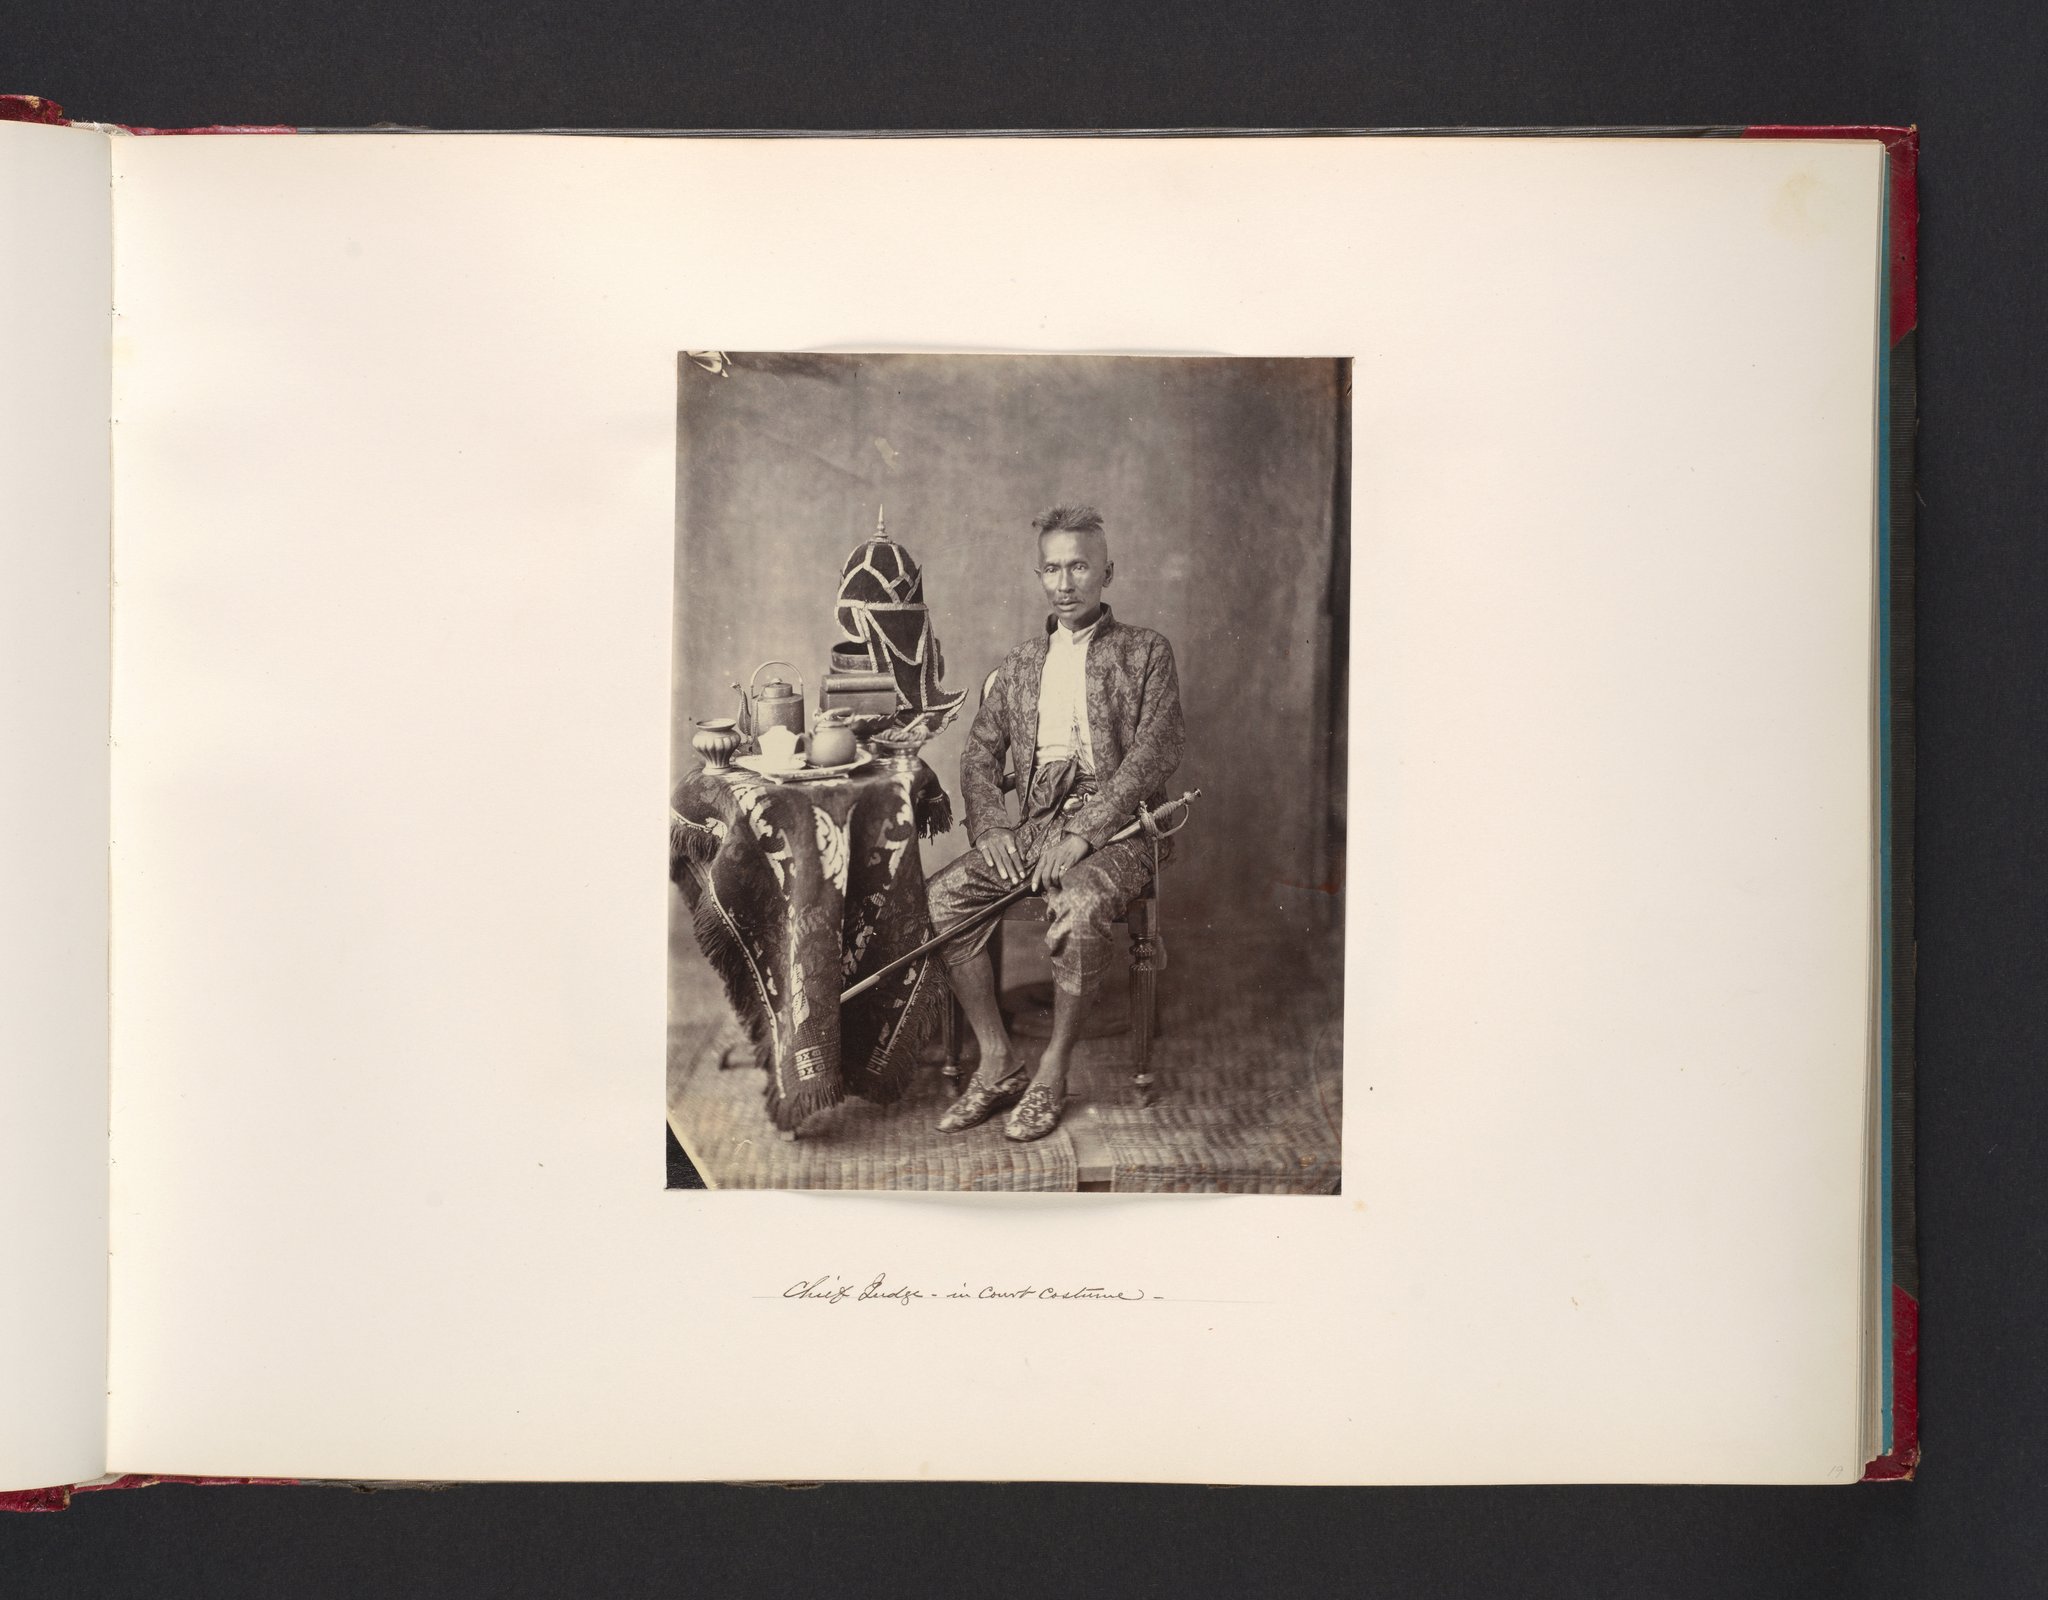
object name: photograph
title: [Chief in Court Costume]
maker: john thomson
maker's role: artist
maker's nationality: british, scottish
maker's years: 1837-1921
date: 1865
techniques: albumen silver print, glass negative